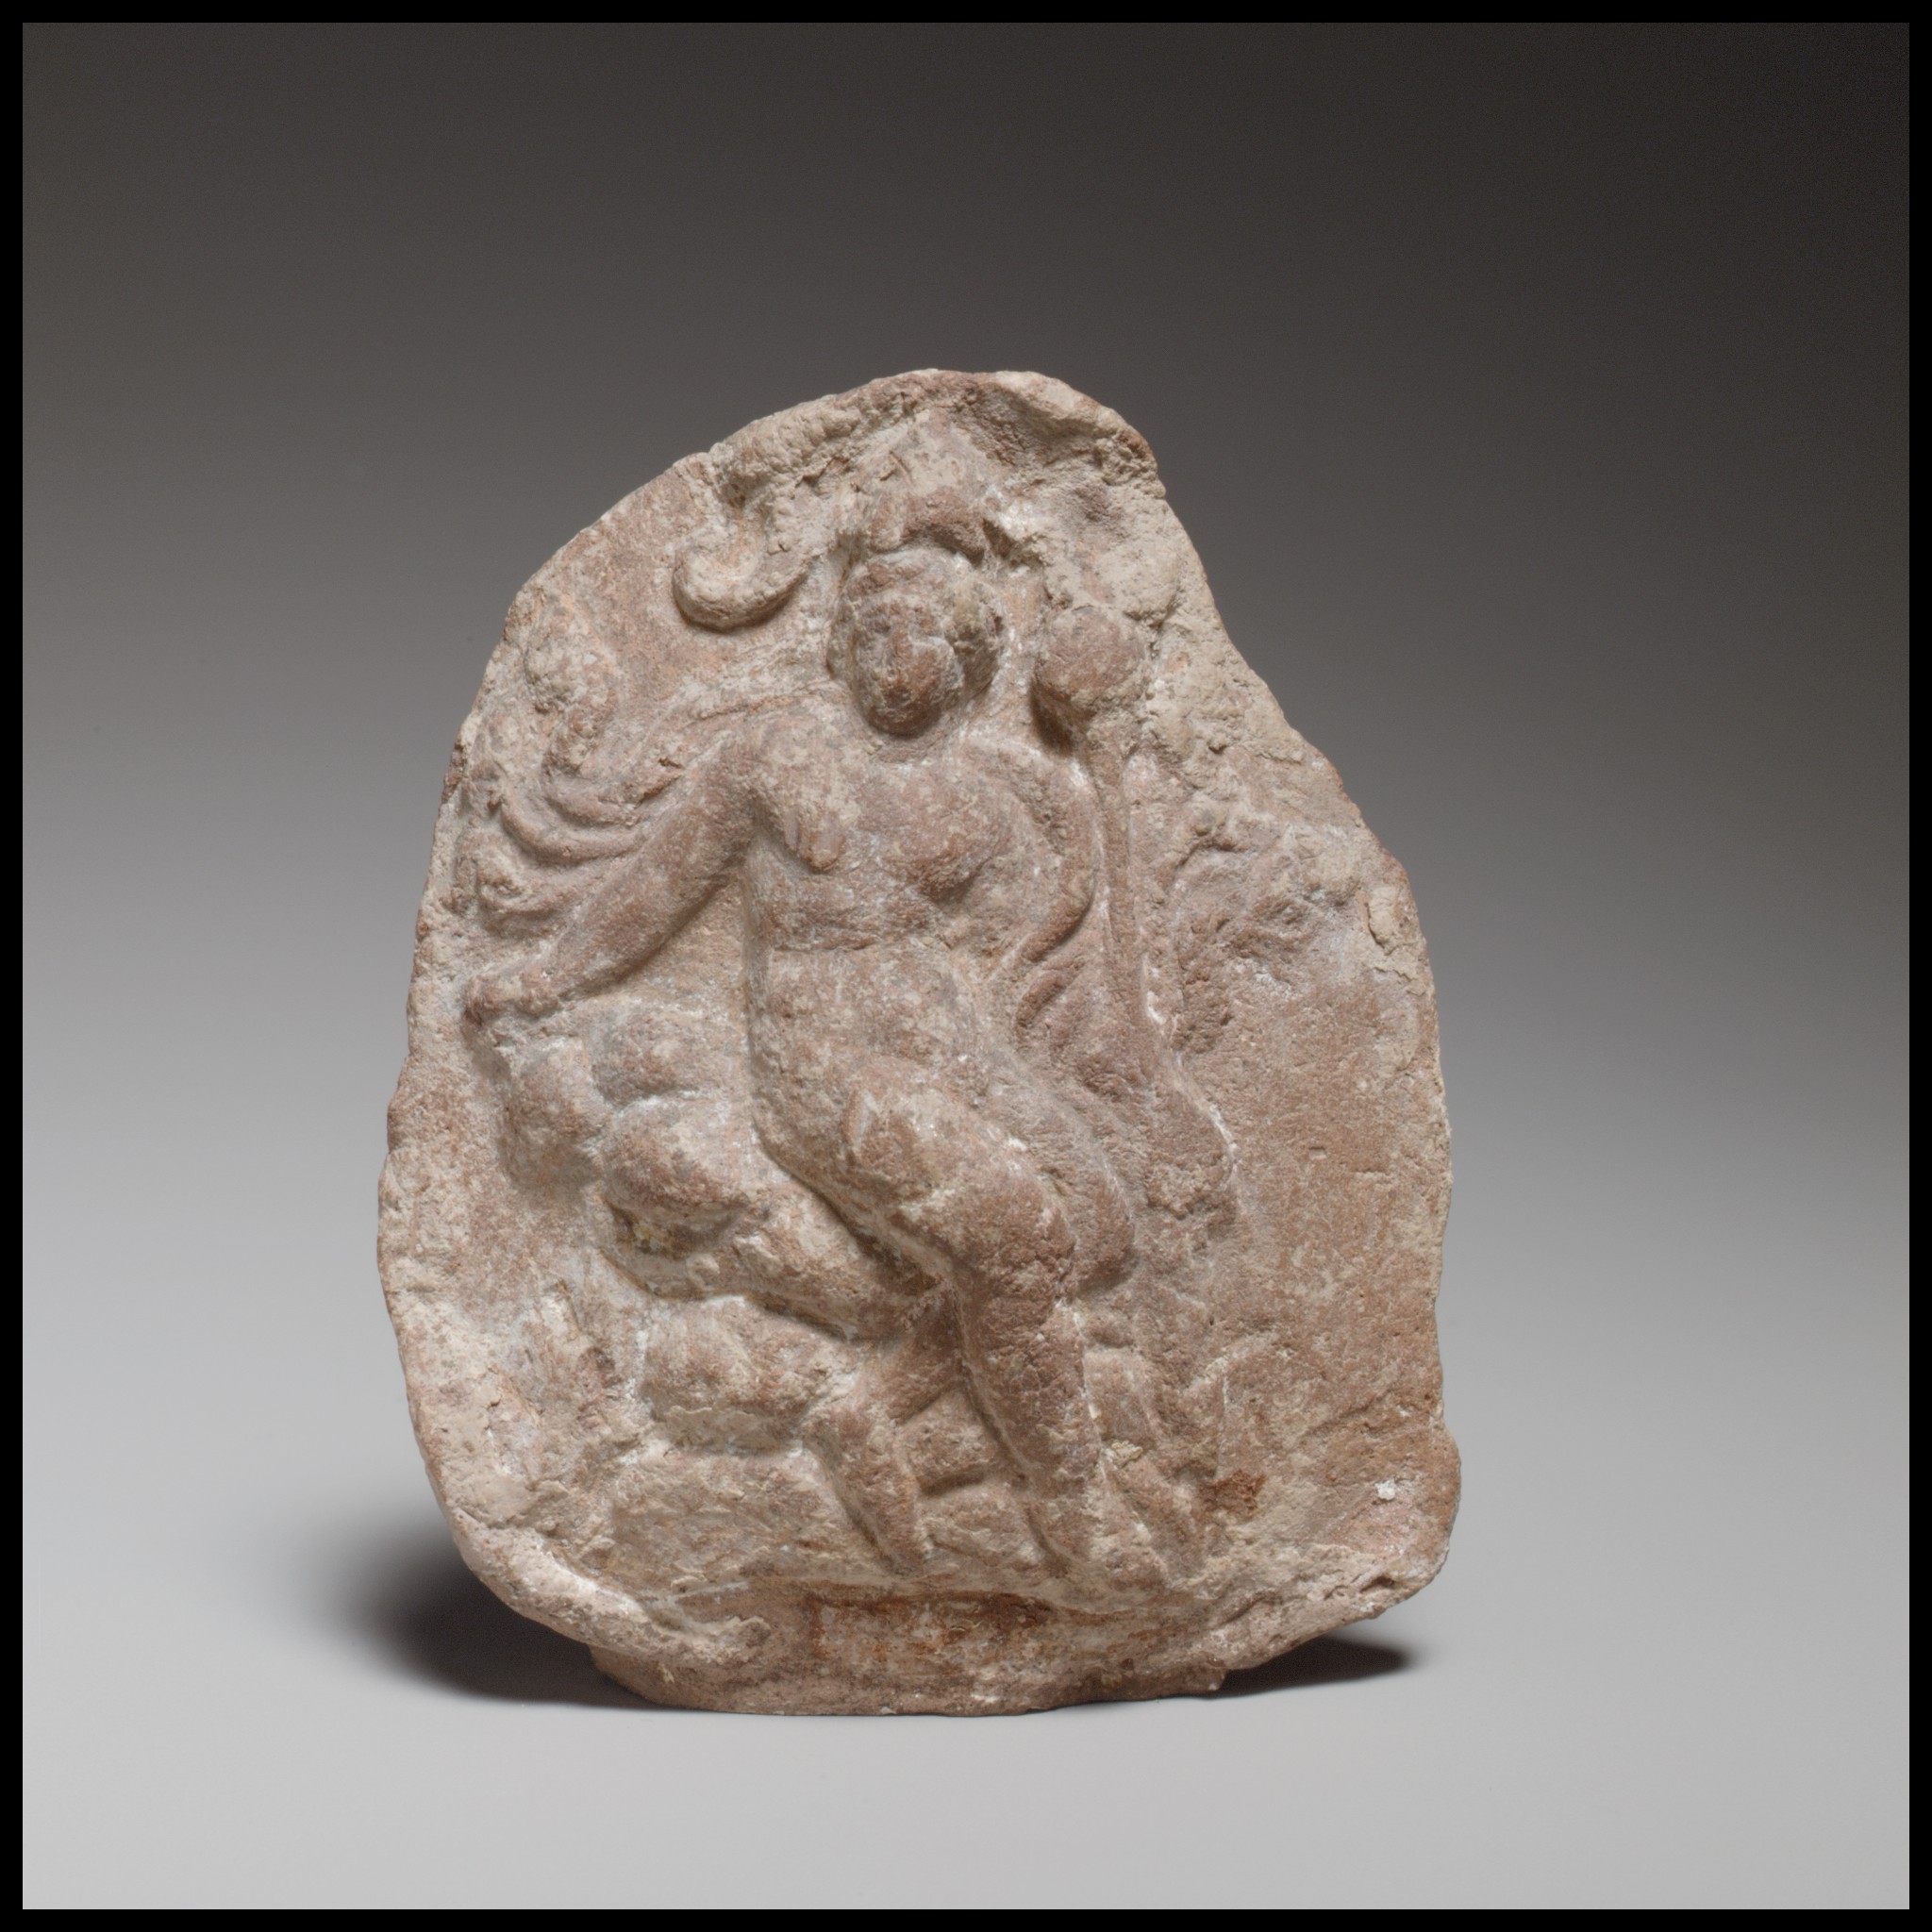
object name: relief of a deity, male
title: Relief depicting a seated figure, probably Dionysos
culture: cypriot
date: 200-1 BCE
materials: terracotta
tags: dionysus